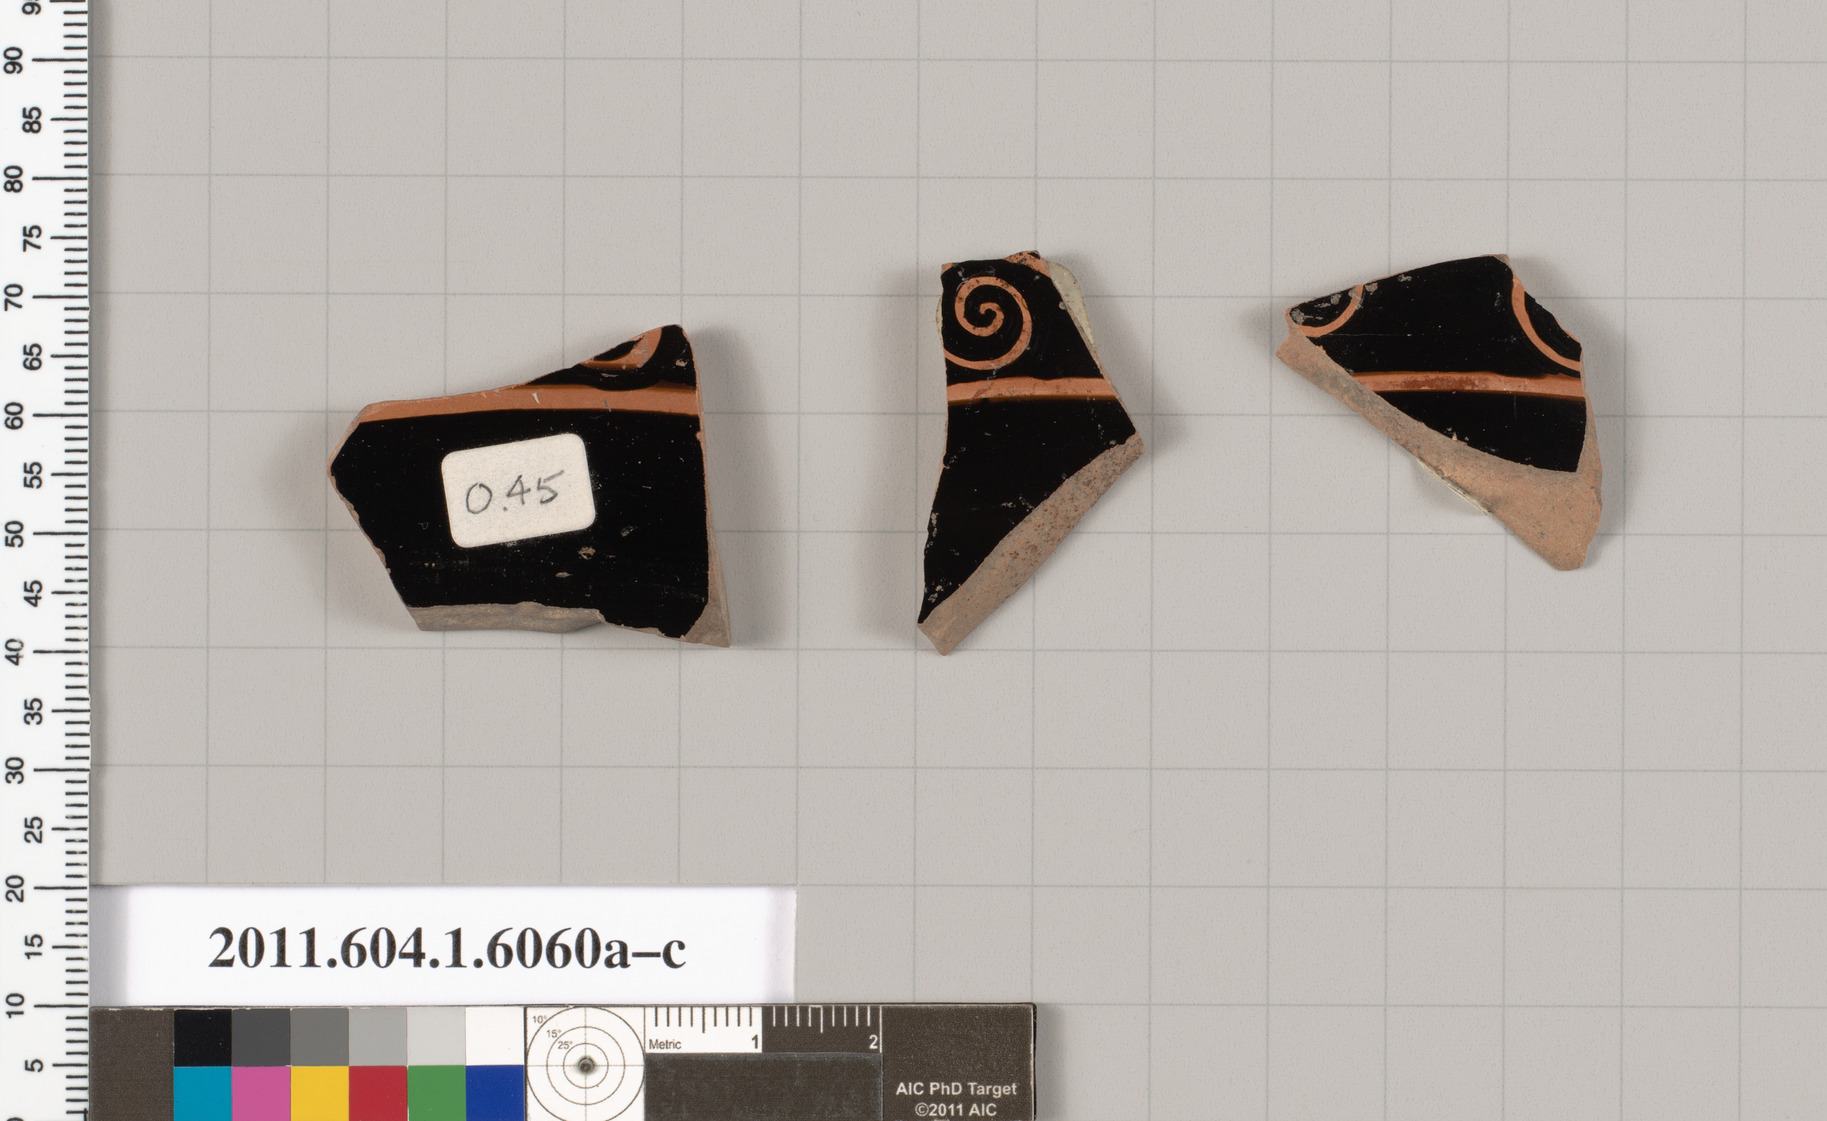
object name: kylix fragment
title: Terracotta fragments of kylikes (drinking cups)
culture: greek, attic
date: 510-500 BCE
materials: terracotta